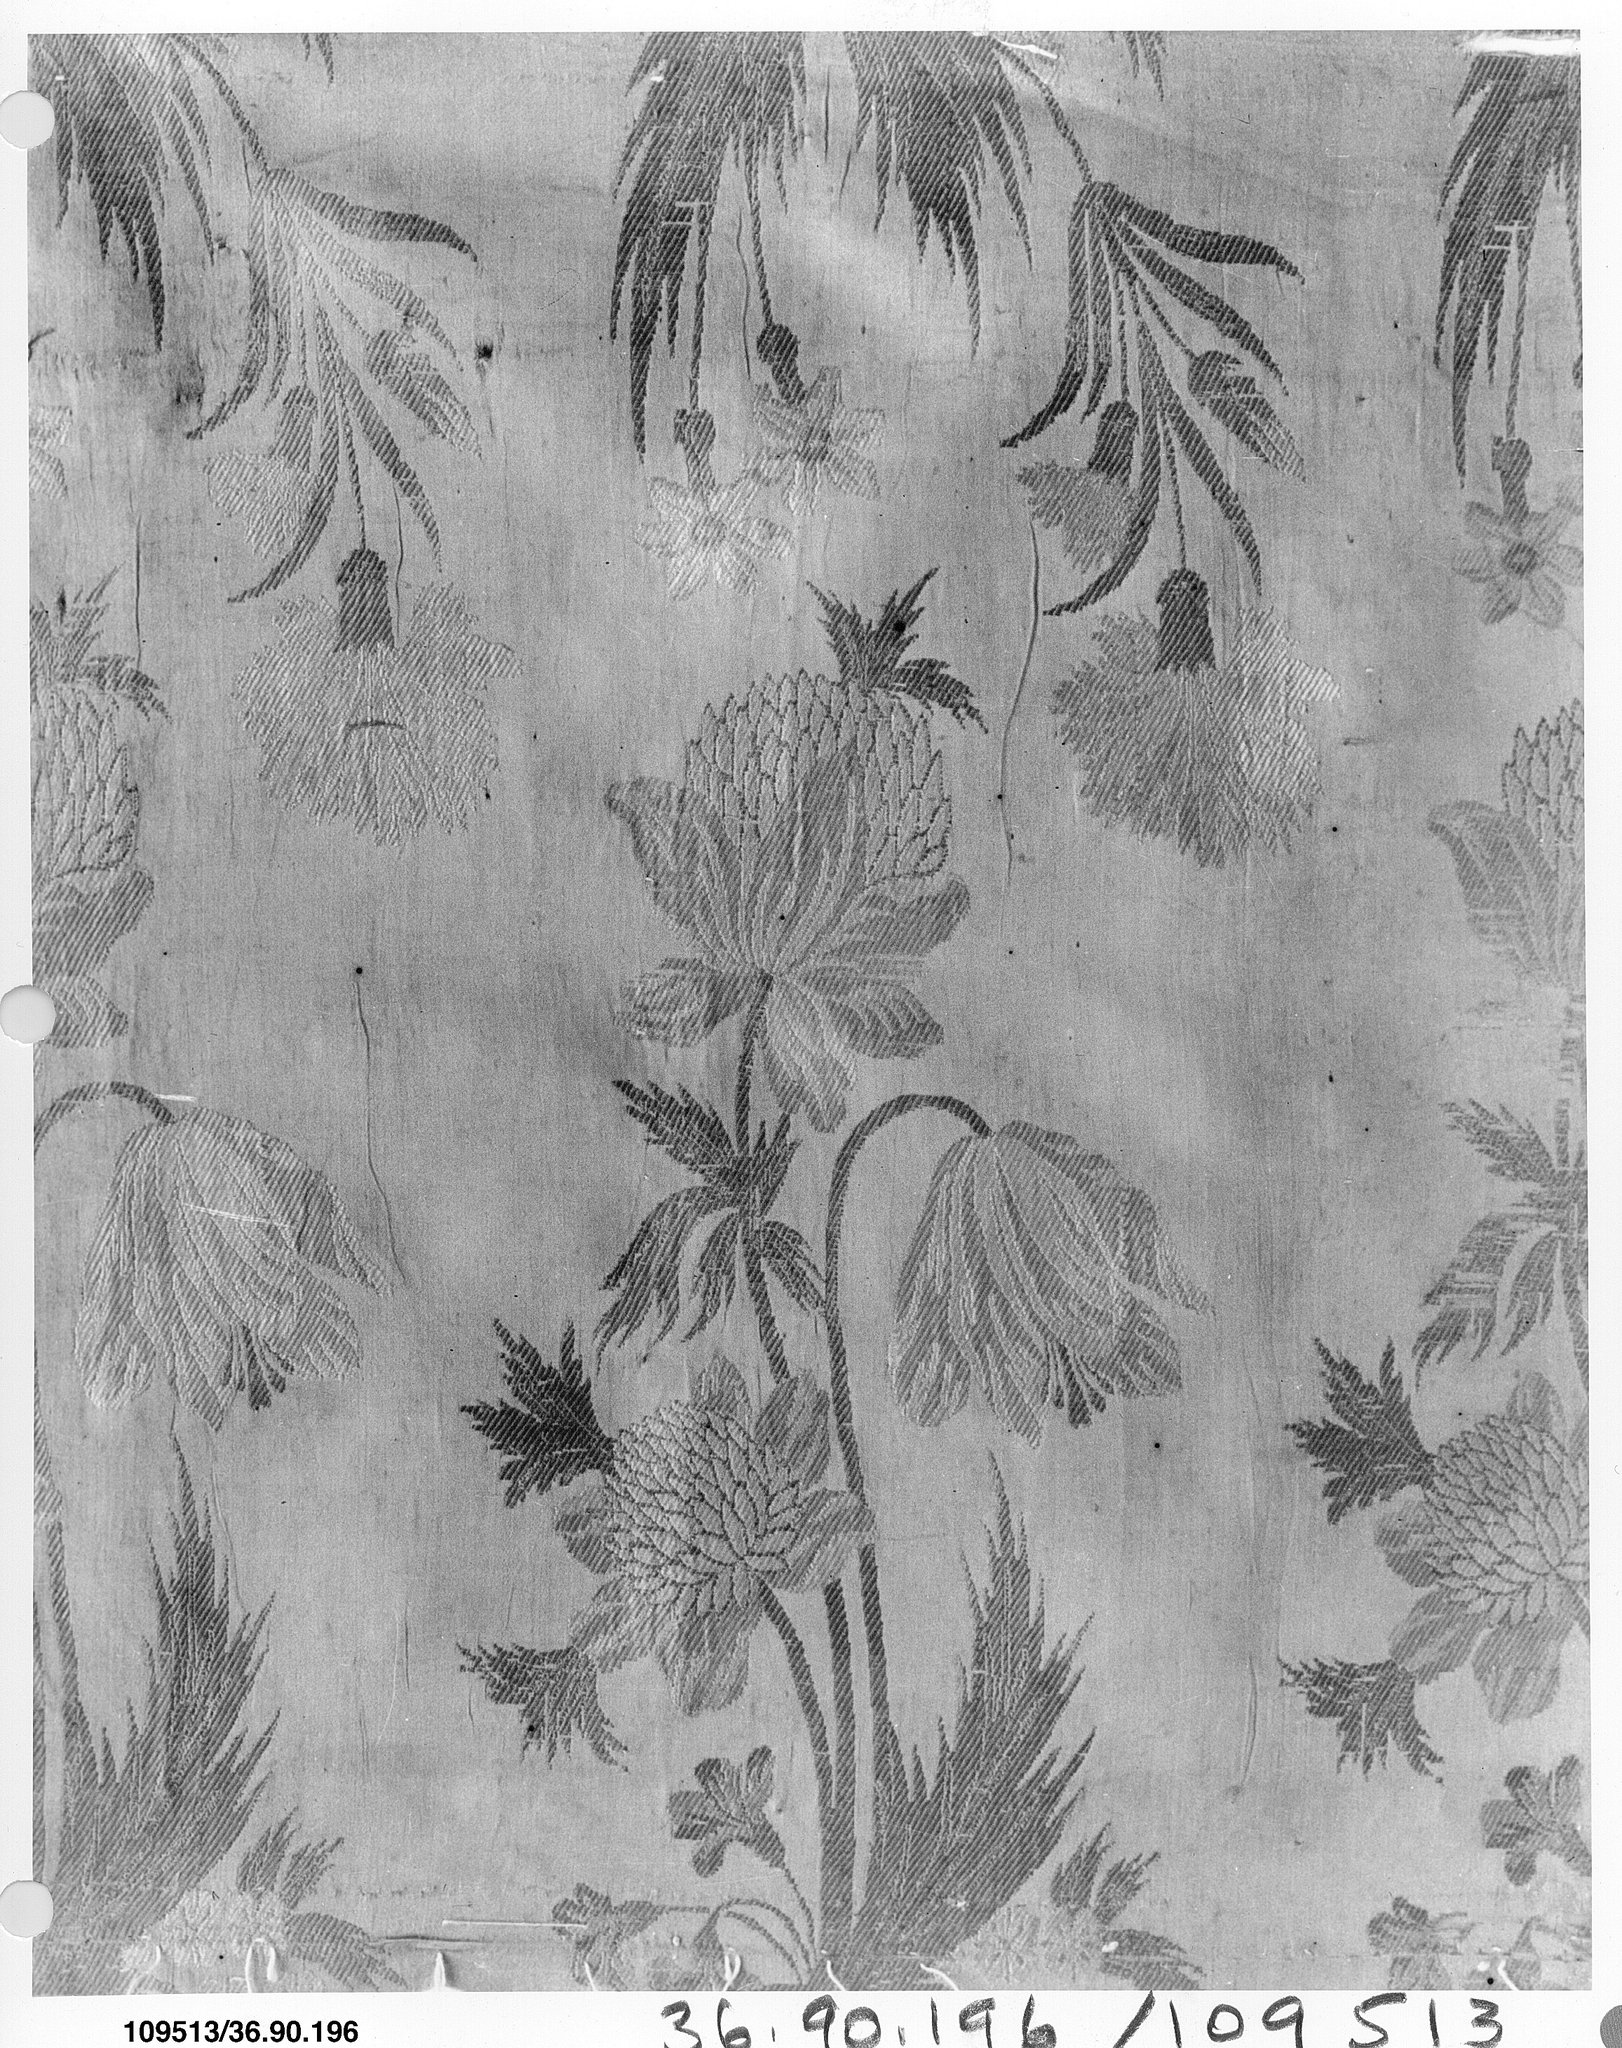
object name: piece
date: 1730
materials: silk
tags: flowers,leaves